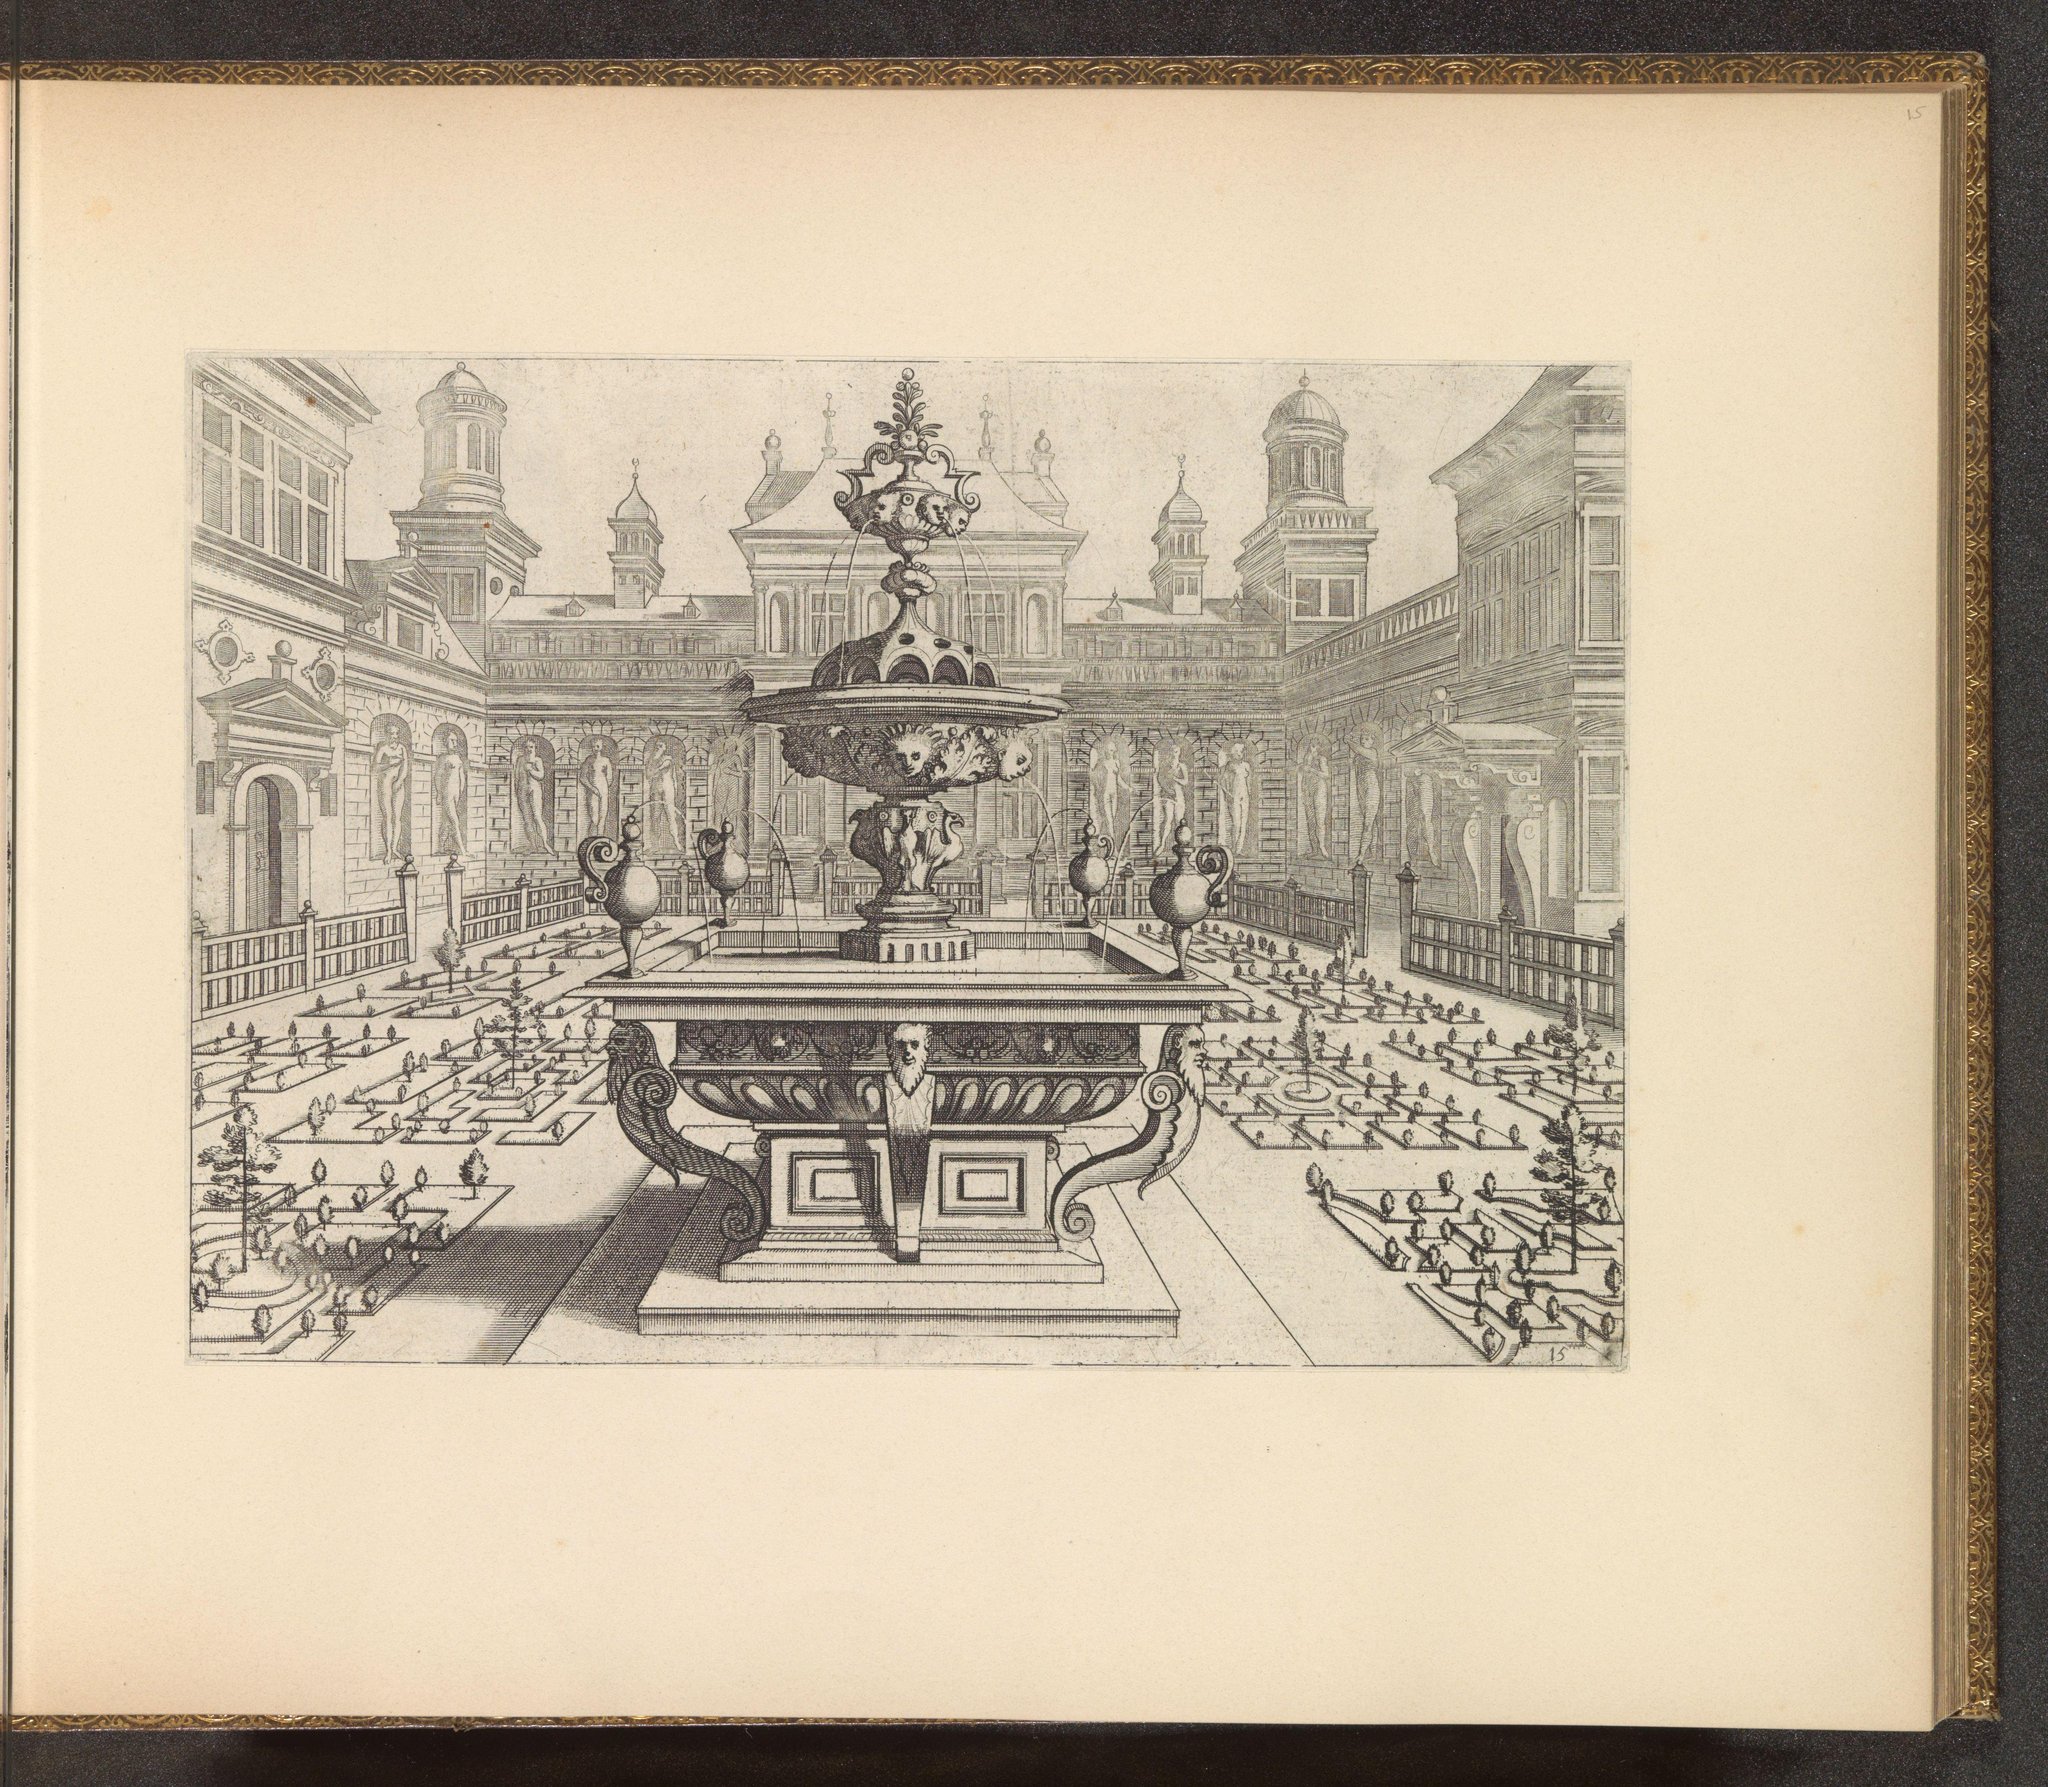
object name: ornament print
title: Binnentuin van een paleis met aan de façade standbeelden in muurnissen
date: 1600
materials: paper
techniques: etching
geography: antwerp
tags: palace, ornamental fountain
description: Ommuurde tuin van een paleis met standbeelden in muurnissen. In het midden een fontein, bestaande uit een vierkant bekken op een voetstuk. Water spuitende vazen staan op de vier hoeken van het bekken. In het midden van het bekken staat een vaasvormige decoratieve bekroning. De prent maakt deel uit van een album.